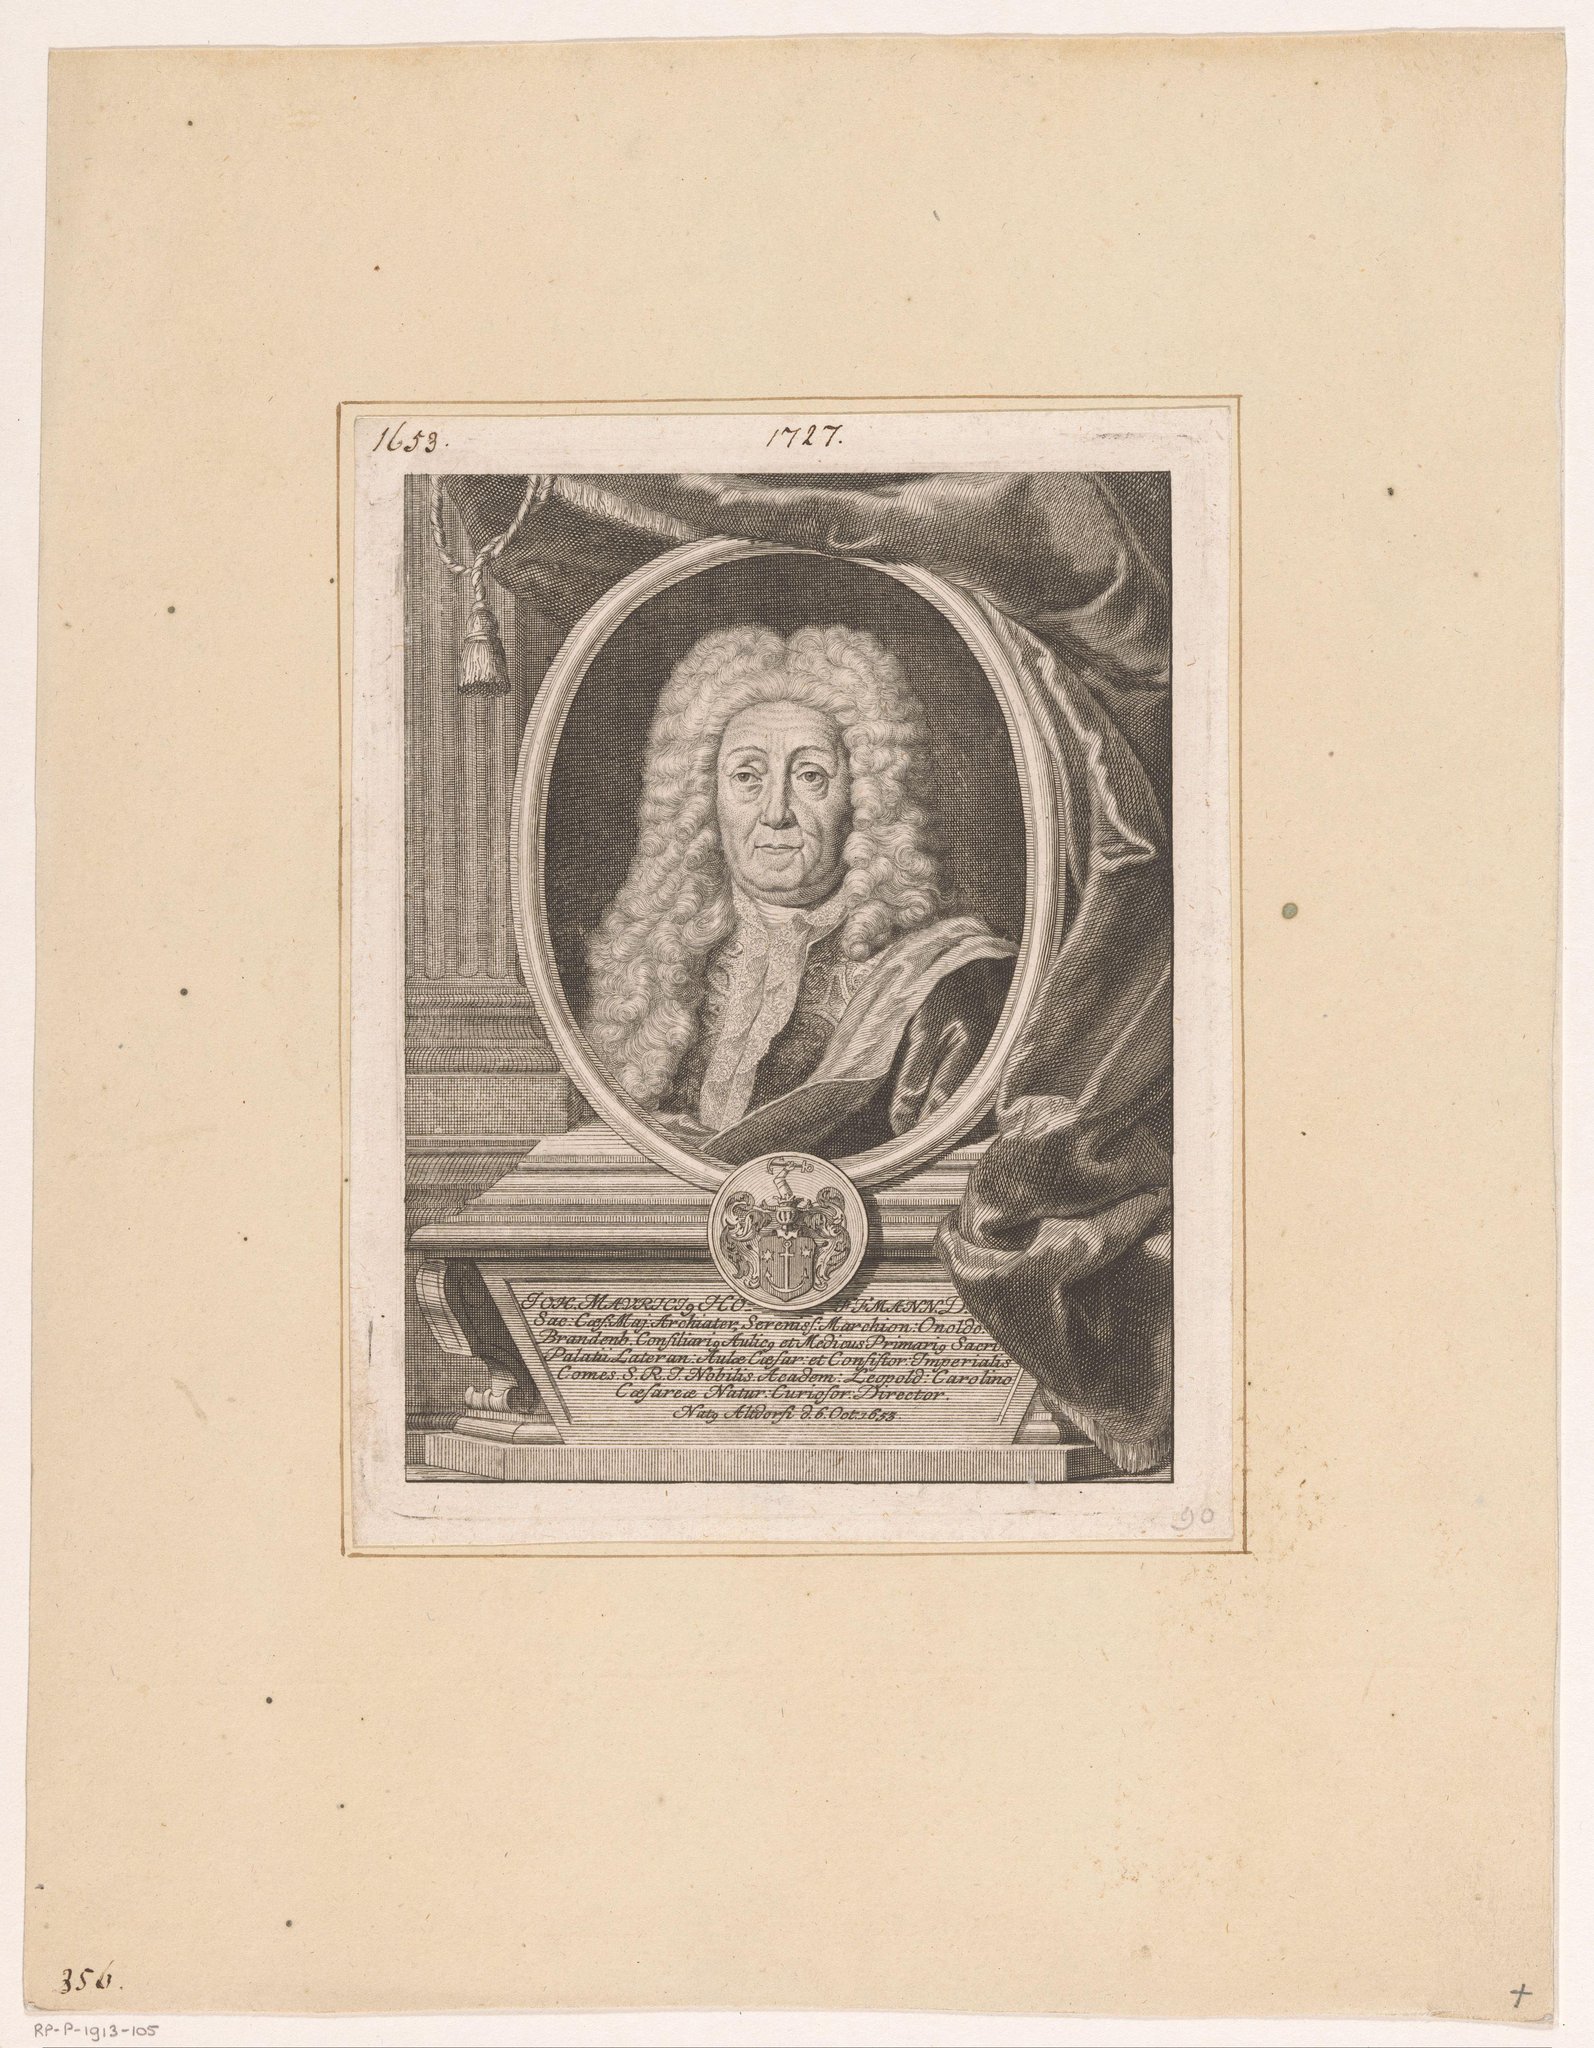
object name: print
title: Portret van Johann Moritz Hoffmann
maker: georg lichtensteger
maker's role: print maker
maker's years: 1700-1781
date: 1710-1781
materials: paper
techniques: engraving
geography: nuremberg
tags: historical persons, armorial bearing, heraldry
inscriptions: inscription: ‘1653/ 1727’